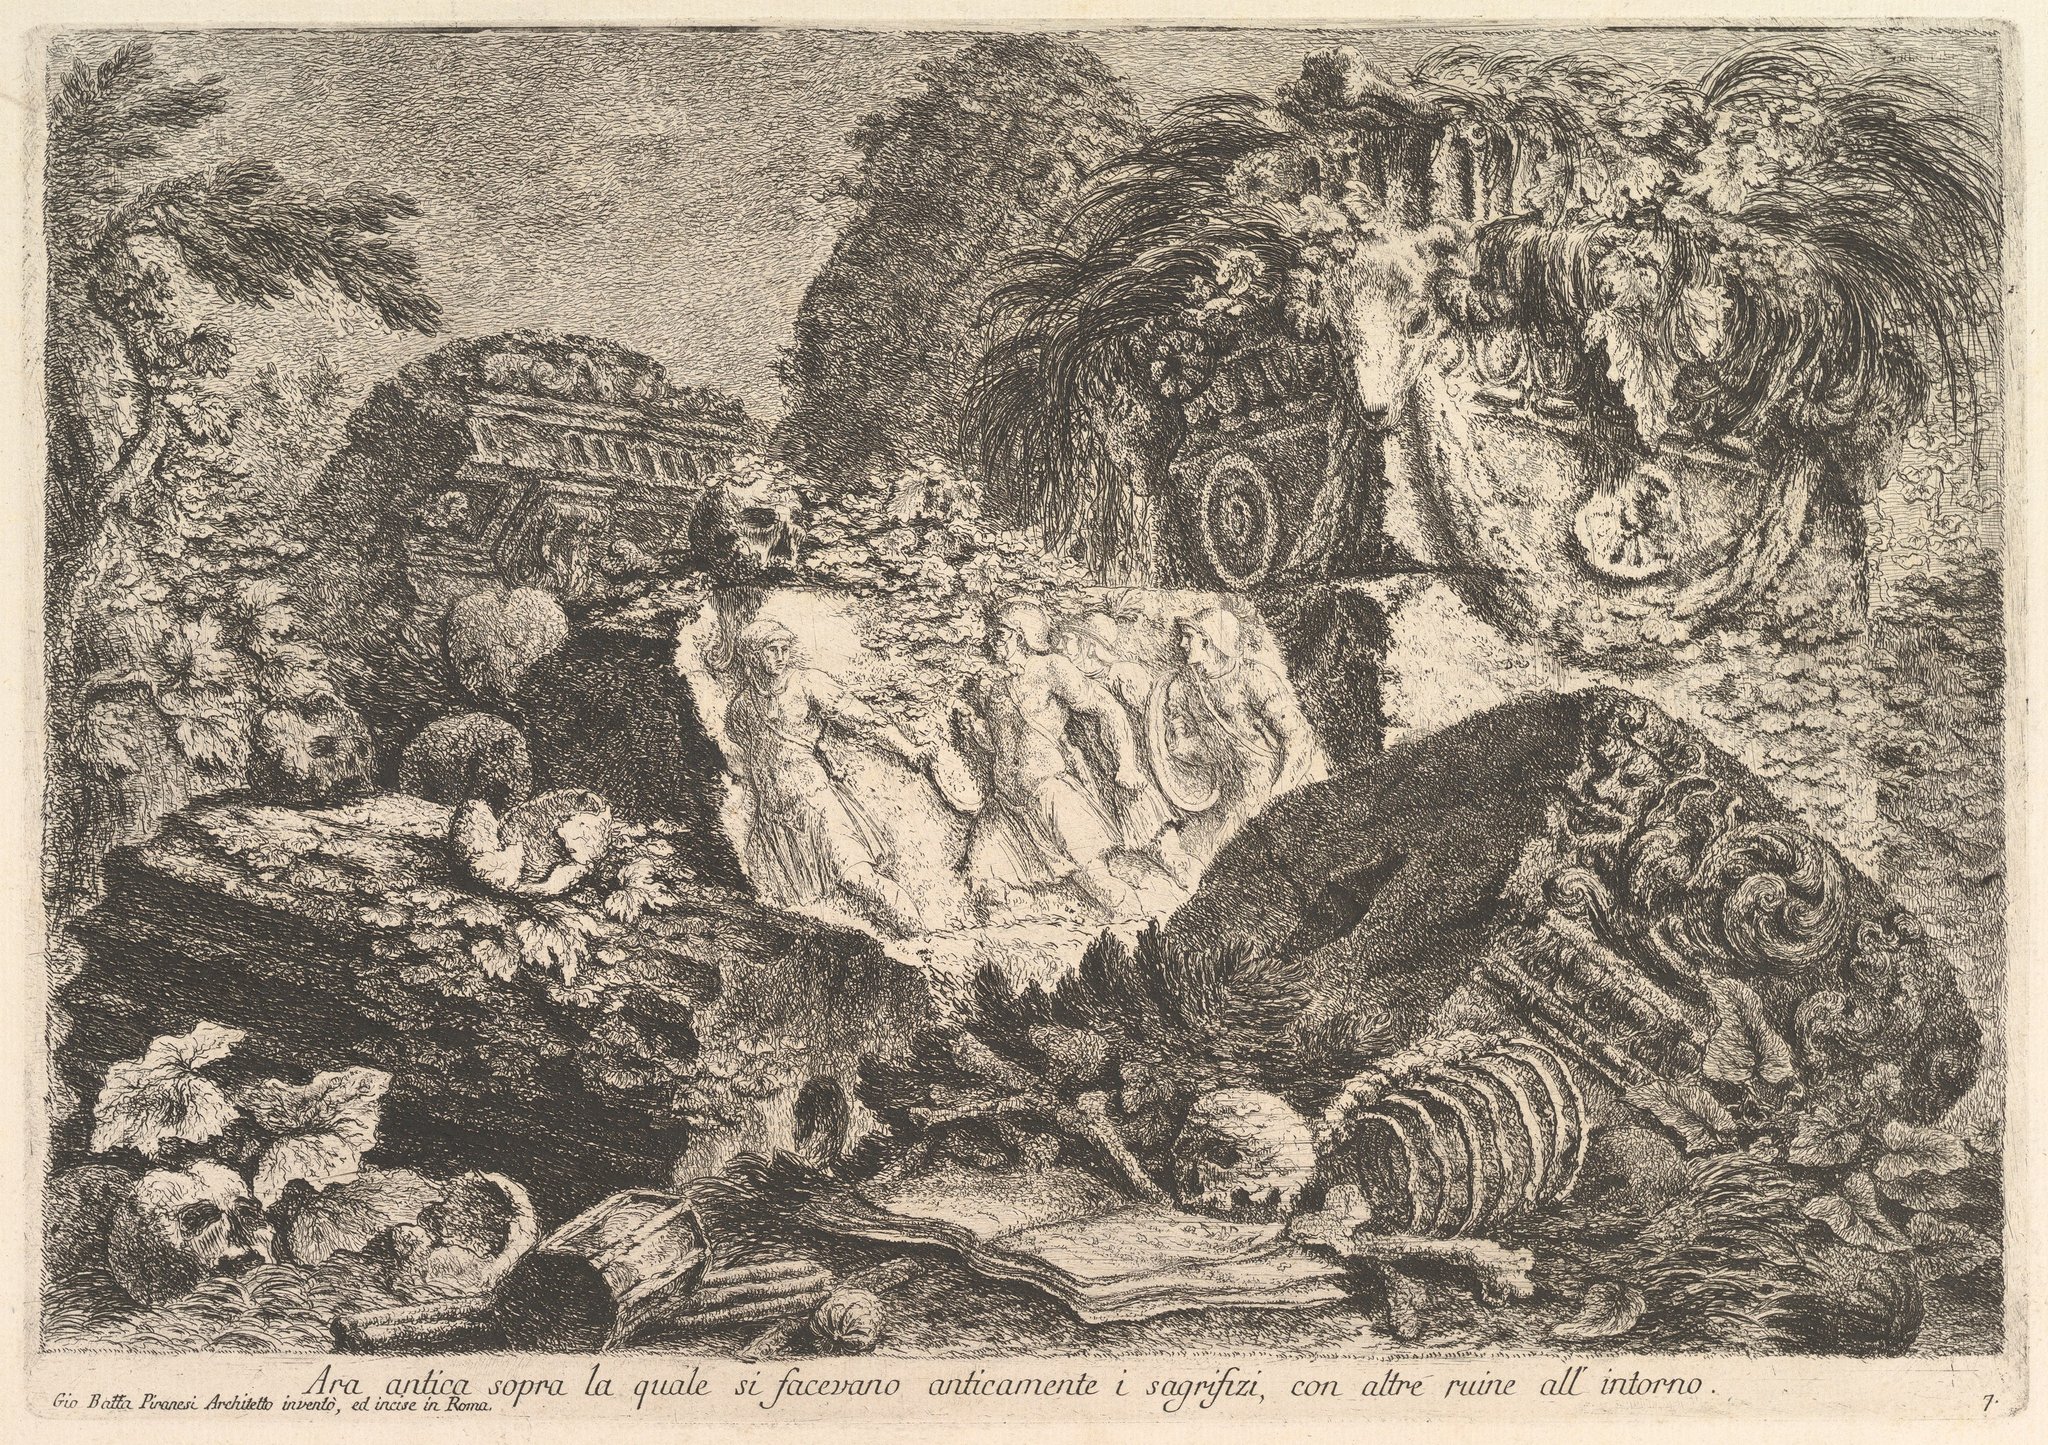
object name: print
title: Ancient Altar on which sacrifices were performed in antiquity, surrounded by other ruins (Ara antica sopra la quale si facevano anticamente i sagrifizi, con altre ruine all'intorno), from "Prima Parte di Architettura, e Prospettive"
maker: giovanni battista piranesi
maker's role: artist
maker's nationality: italian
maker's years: 1720-1778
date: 1750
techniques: etching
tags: ruins,skeletons,men